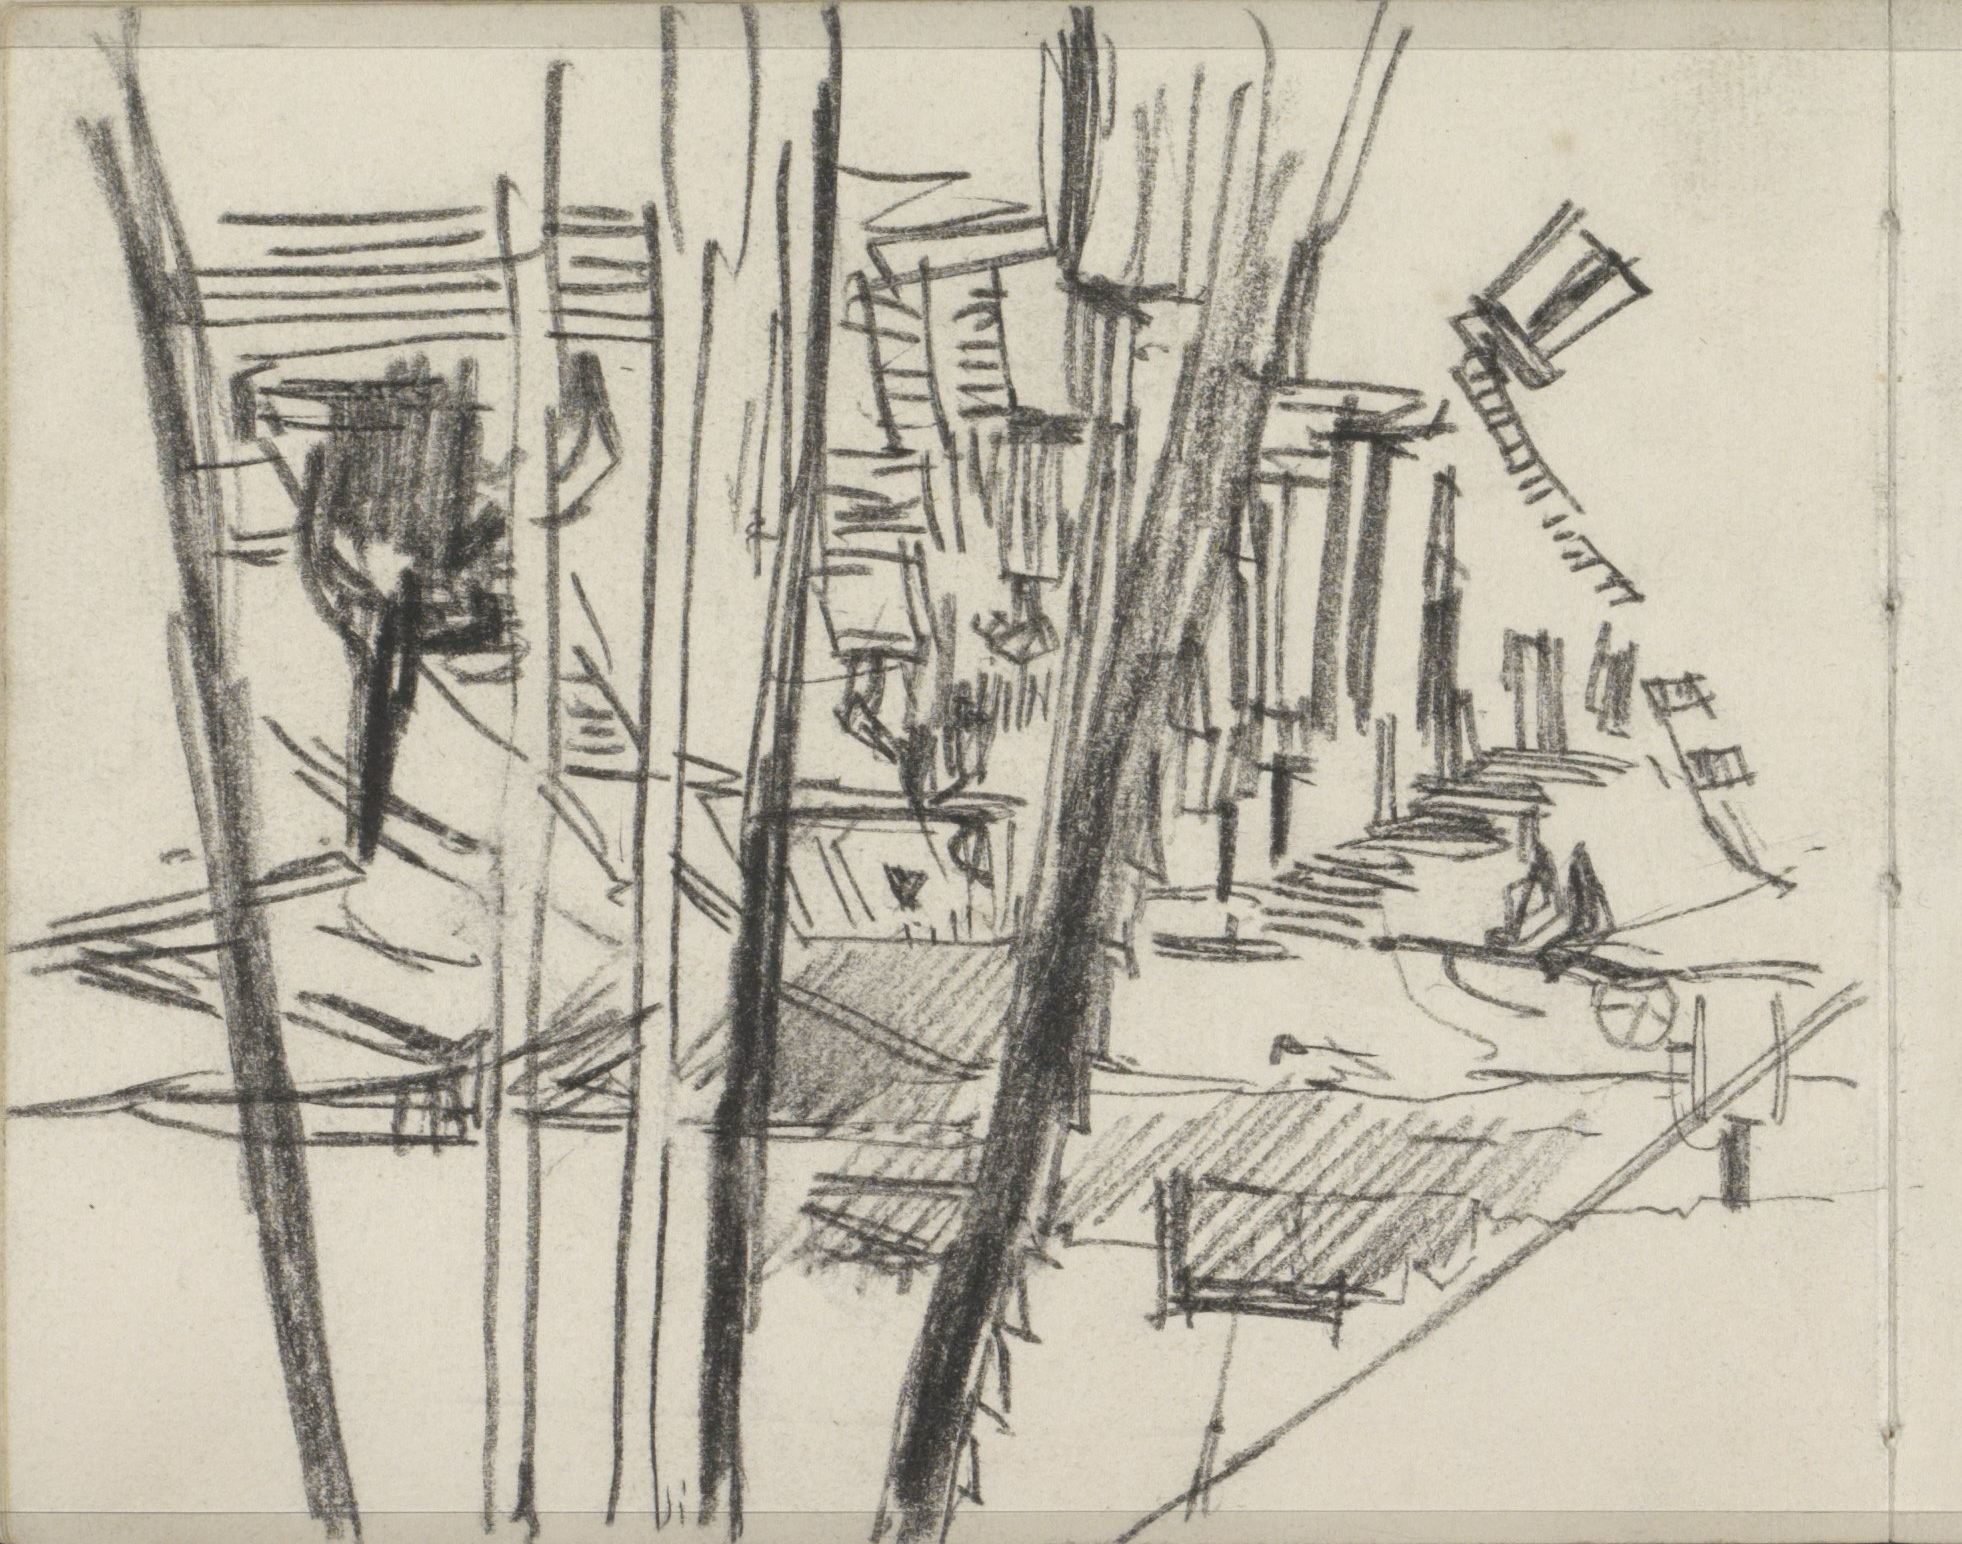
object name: sketchbook leaf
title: Gezicht op heiwerkzaamheden aan de Barentszkade te Amsterdam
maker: george hendrik breitner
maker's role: draughtsman, painter, print maker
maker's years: 1857-1923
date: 1886-1891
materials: chalk, paper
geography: amsterdam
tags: ramming, driving piles (~ building activities), pier, quay, wharf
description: Pagina 37 uit een schetsboek met 32 bladen.